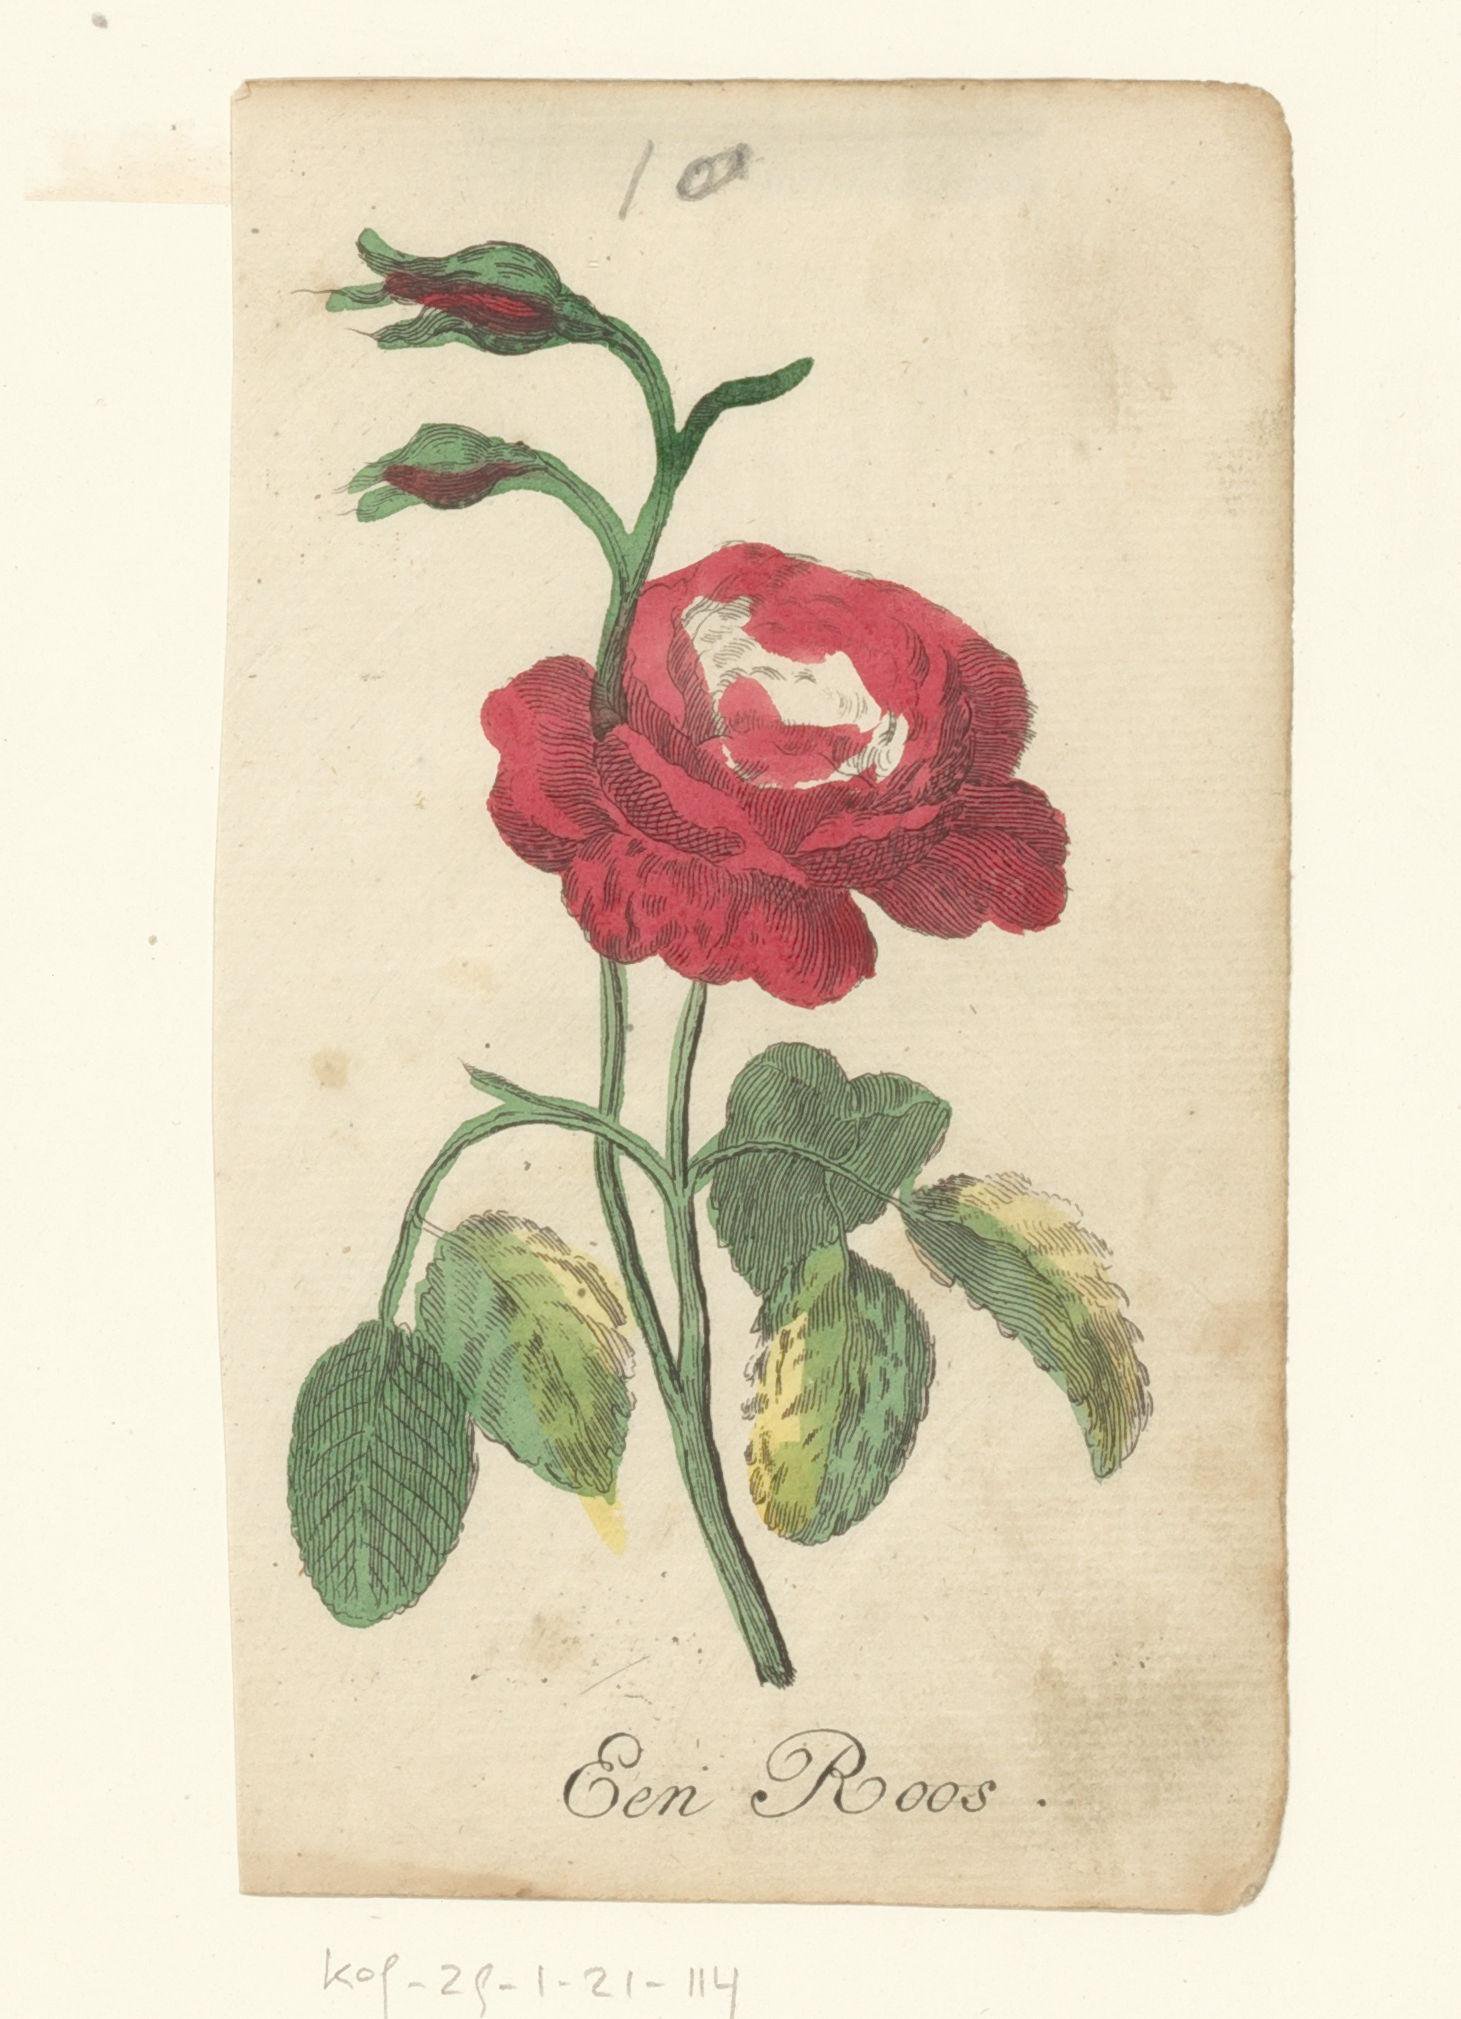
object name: print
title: Een Roos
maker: Anonymous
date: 1793-1800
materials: paper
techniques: engraving, etching, hand coloring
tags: flowers: rose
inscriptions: collector's mark: Lugt 1641, stamp, collector's mark: Lugt 1641a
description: Prent waarschijnlijk uit: De vrolijke Zeden-Meester, voor kinderen. Amsterdam: Johannes Roelof Poster, 1800. Of een andere editie van deze uitgave. Volgens de Atlas van Stolk ook gebruikt in: De nieuwe toverlantaarn. Amsterdam: s.n., 1797.